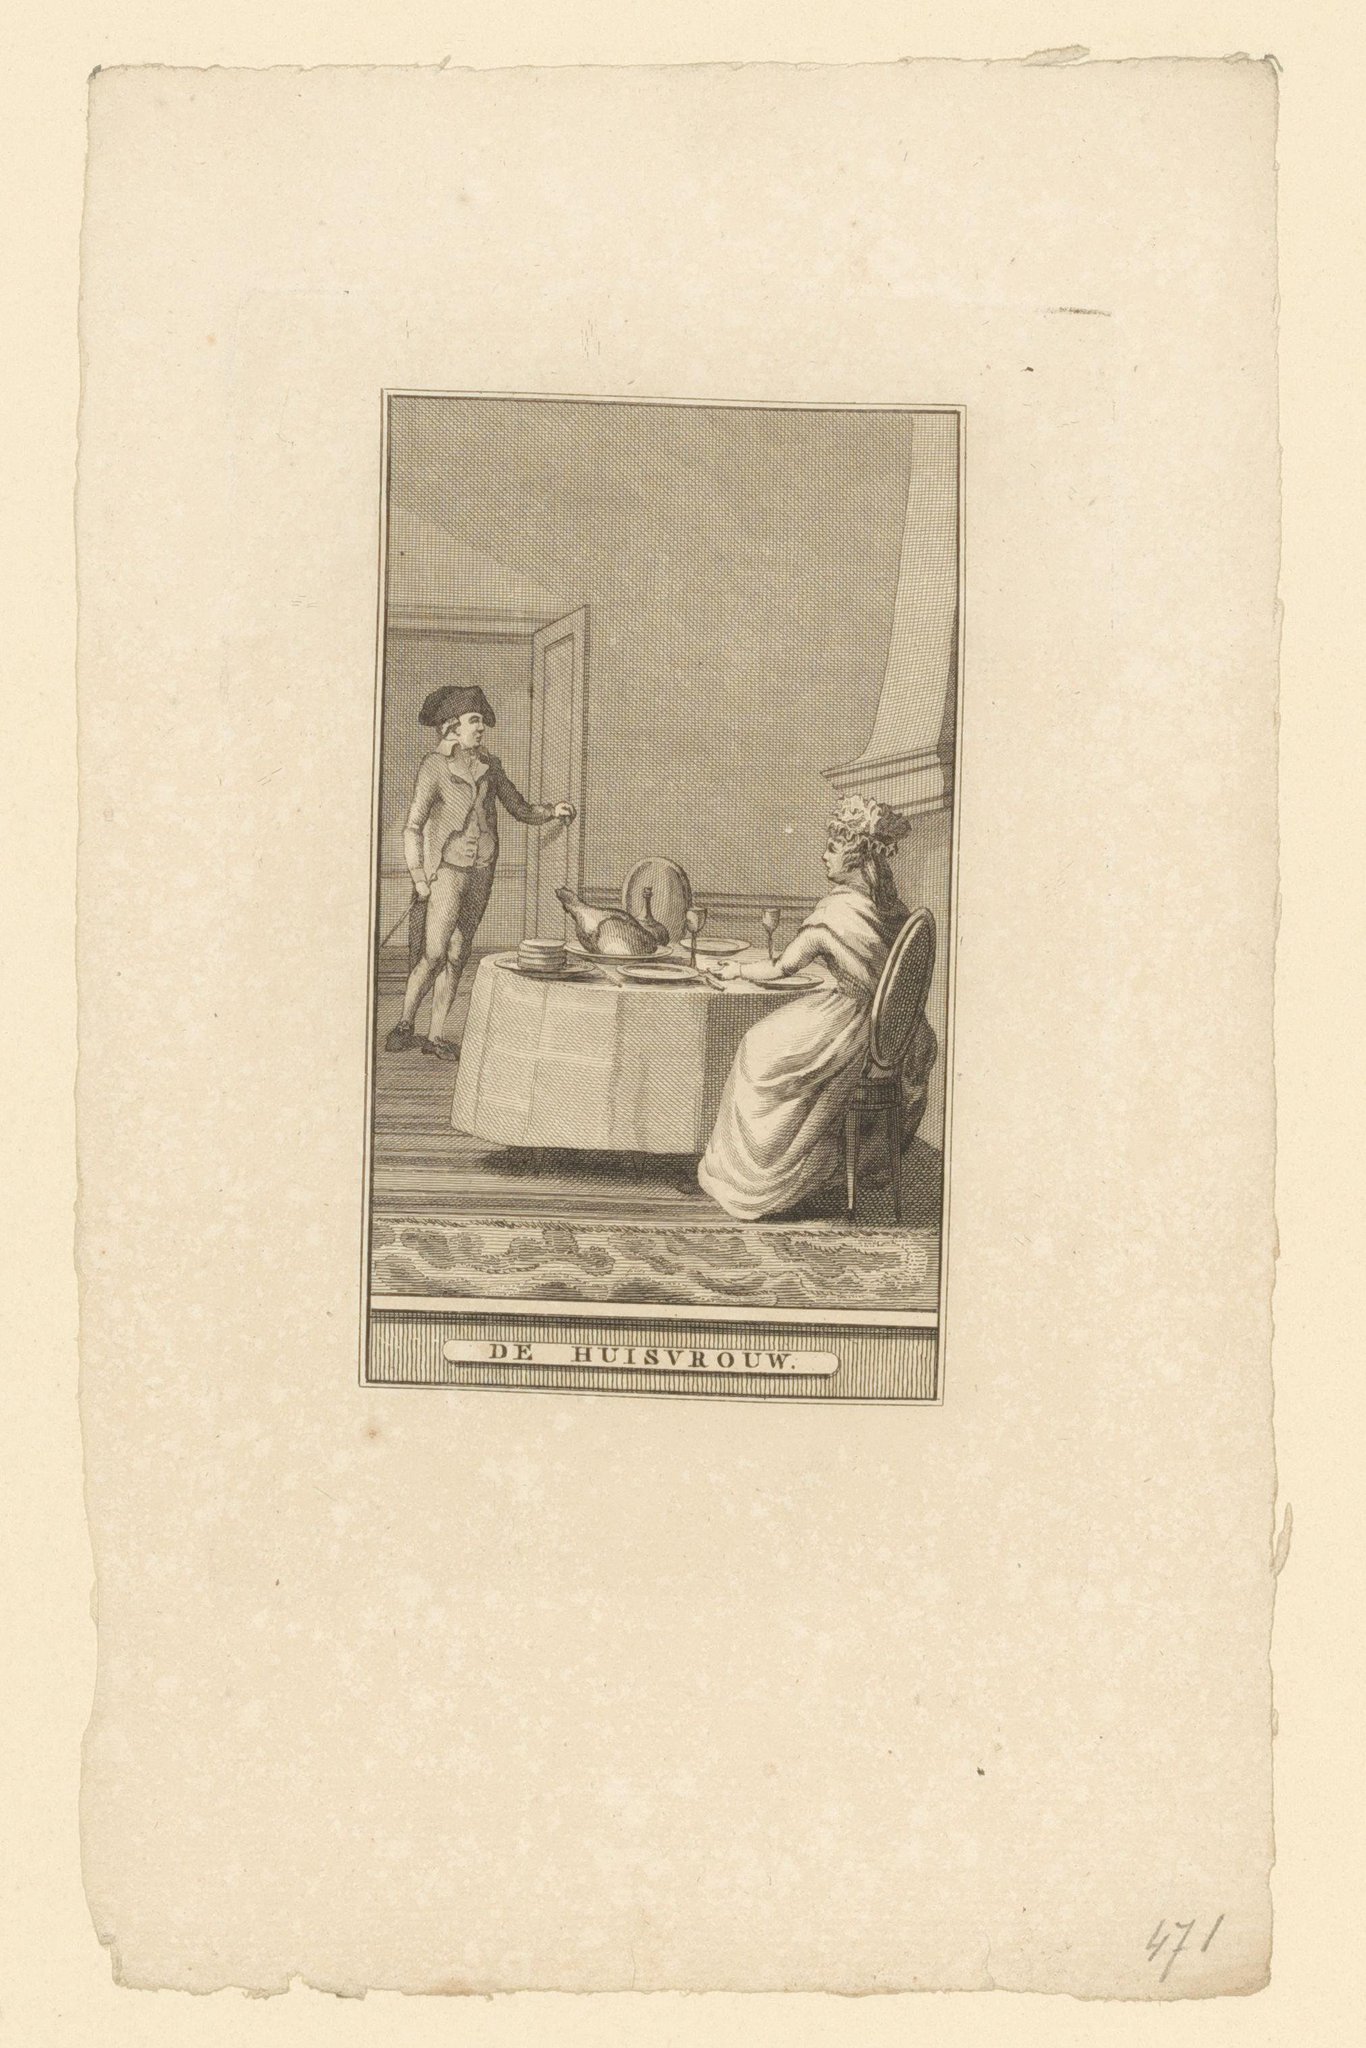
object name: book illustration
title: De Huisvrouw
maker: Anonymous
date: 1798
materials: paper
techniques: engraving, etching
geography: netherlands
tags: communal rooms, family life at home, laid table: table-ware, table-decoration, etc., (family) meal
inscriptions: collector's mark, collector's mark: Lugt 1641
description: Gebruikt als illustratie in: E. Bekker en A. Deken, Economische liedjes, Amsterdam: Johannes Allart, 1798, dl. 2. p. 394/395.